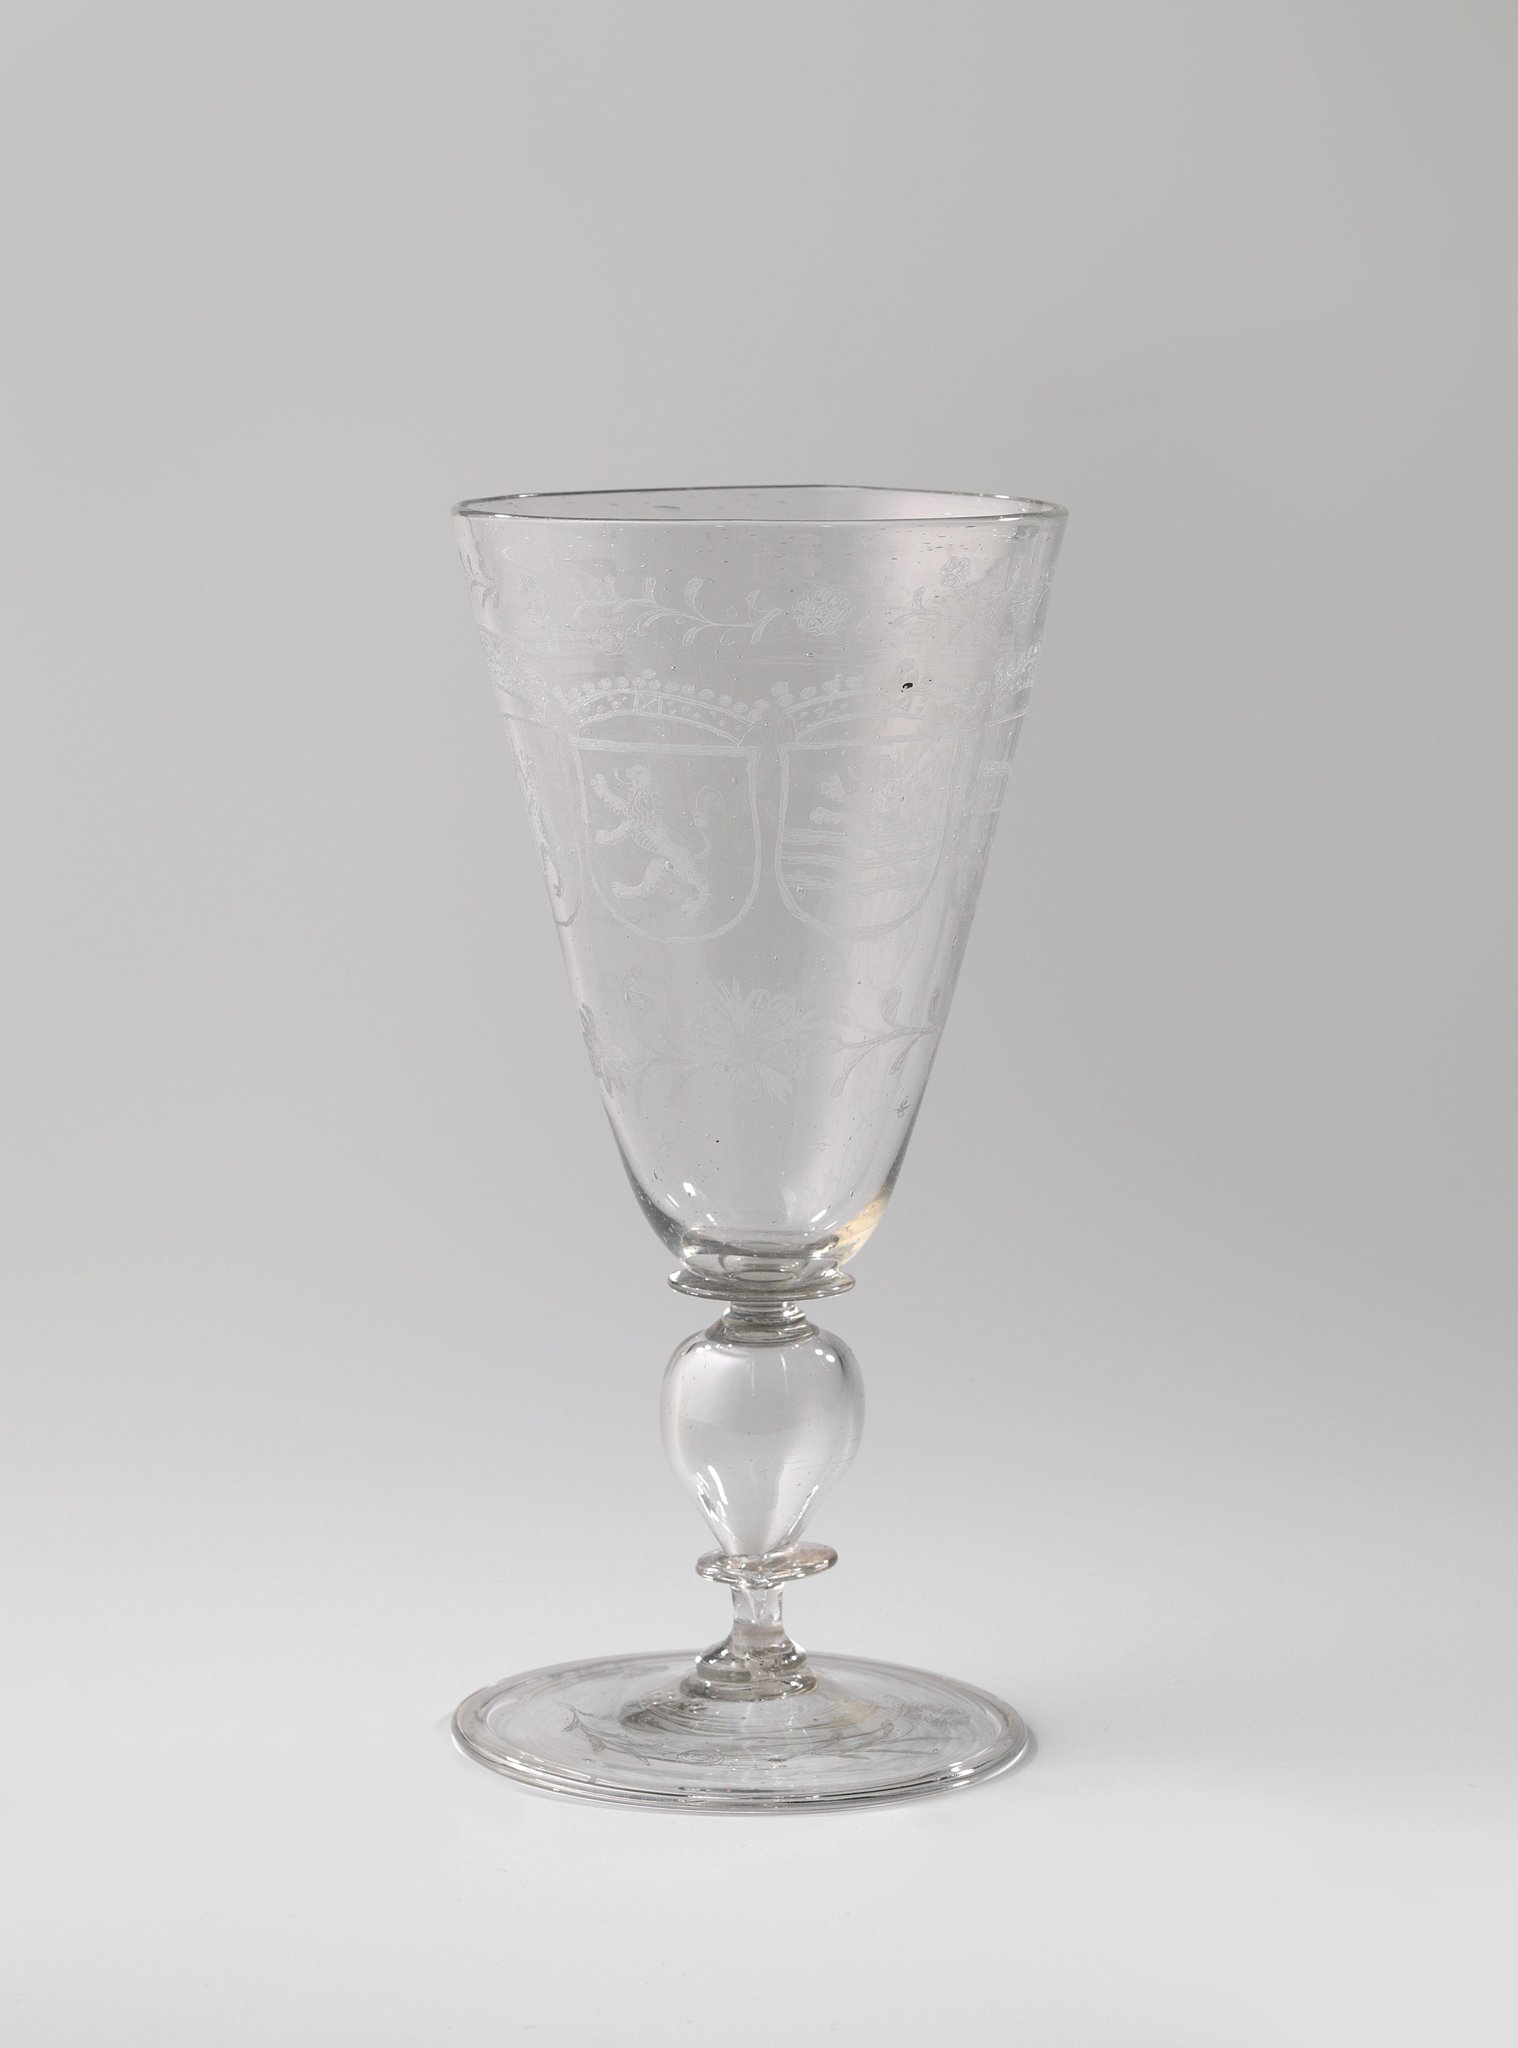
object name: goblet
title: Kelkglas met de wapens van de Zeven Provinciën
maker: Anonymous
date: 1675-1700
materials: glass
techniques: diamond point engraving, façon de venise, glassblowing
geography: northern netherlands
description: Platte voet met omgeslagen rand en pontilmerk. Holle, balustervormige stam met twee schijven. Trechtervormige, aan de onderzijde afgeronde kelk. Op de kelk zijn de wapens der Zeven Provinciën gegraveerd, waarbij het wapen van de provincie Groningen groter is afgebeeld dan dat van de overige provincies. Boven en onder de wapens zijn bloemtakken gegraveerd.